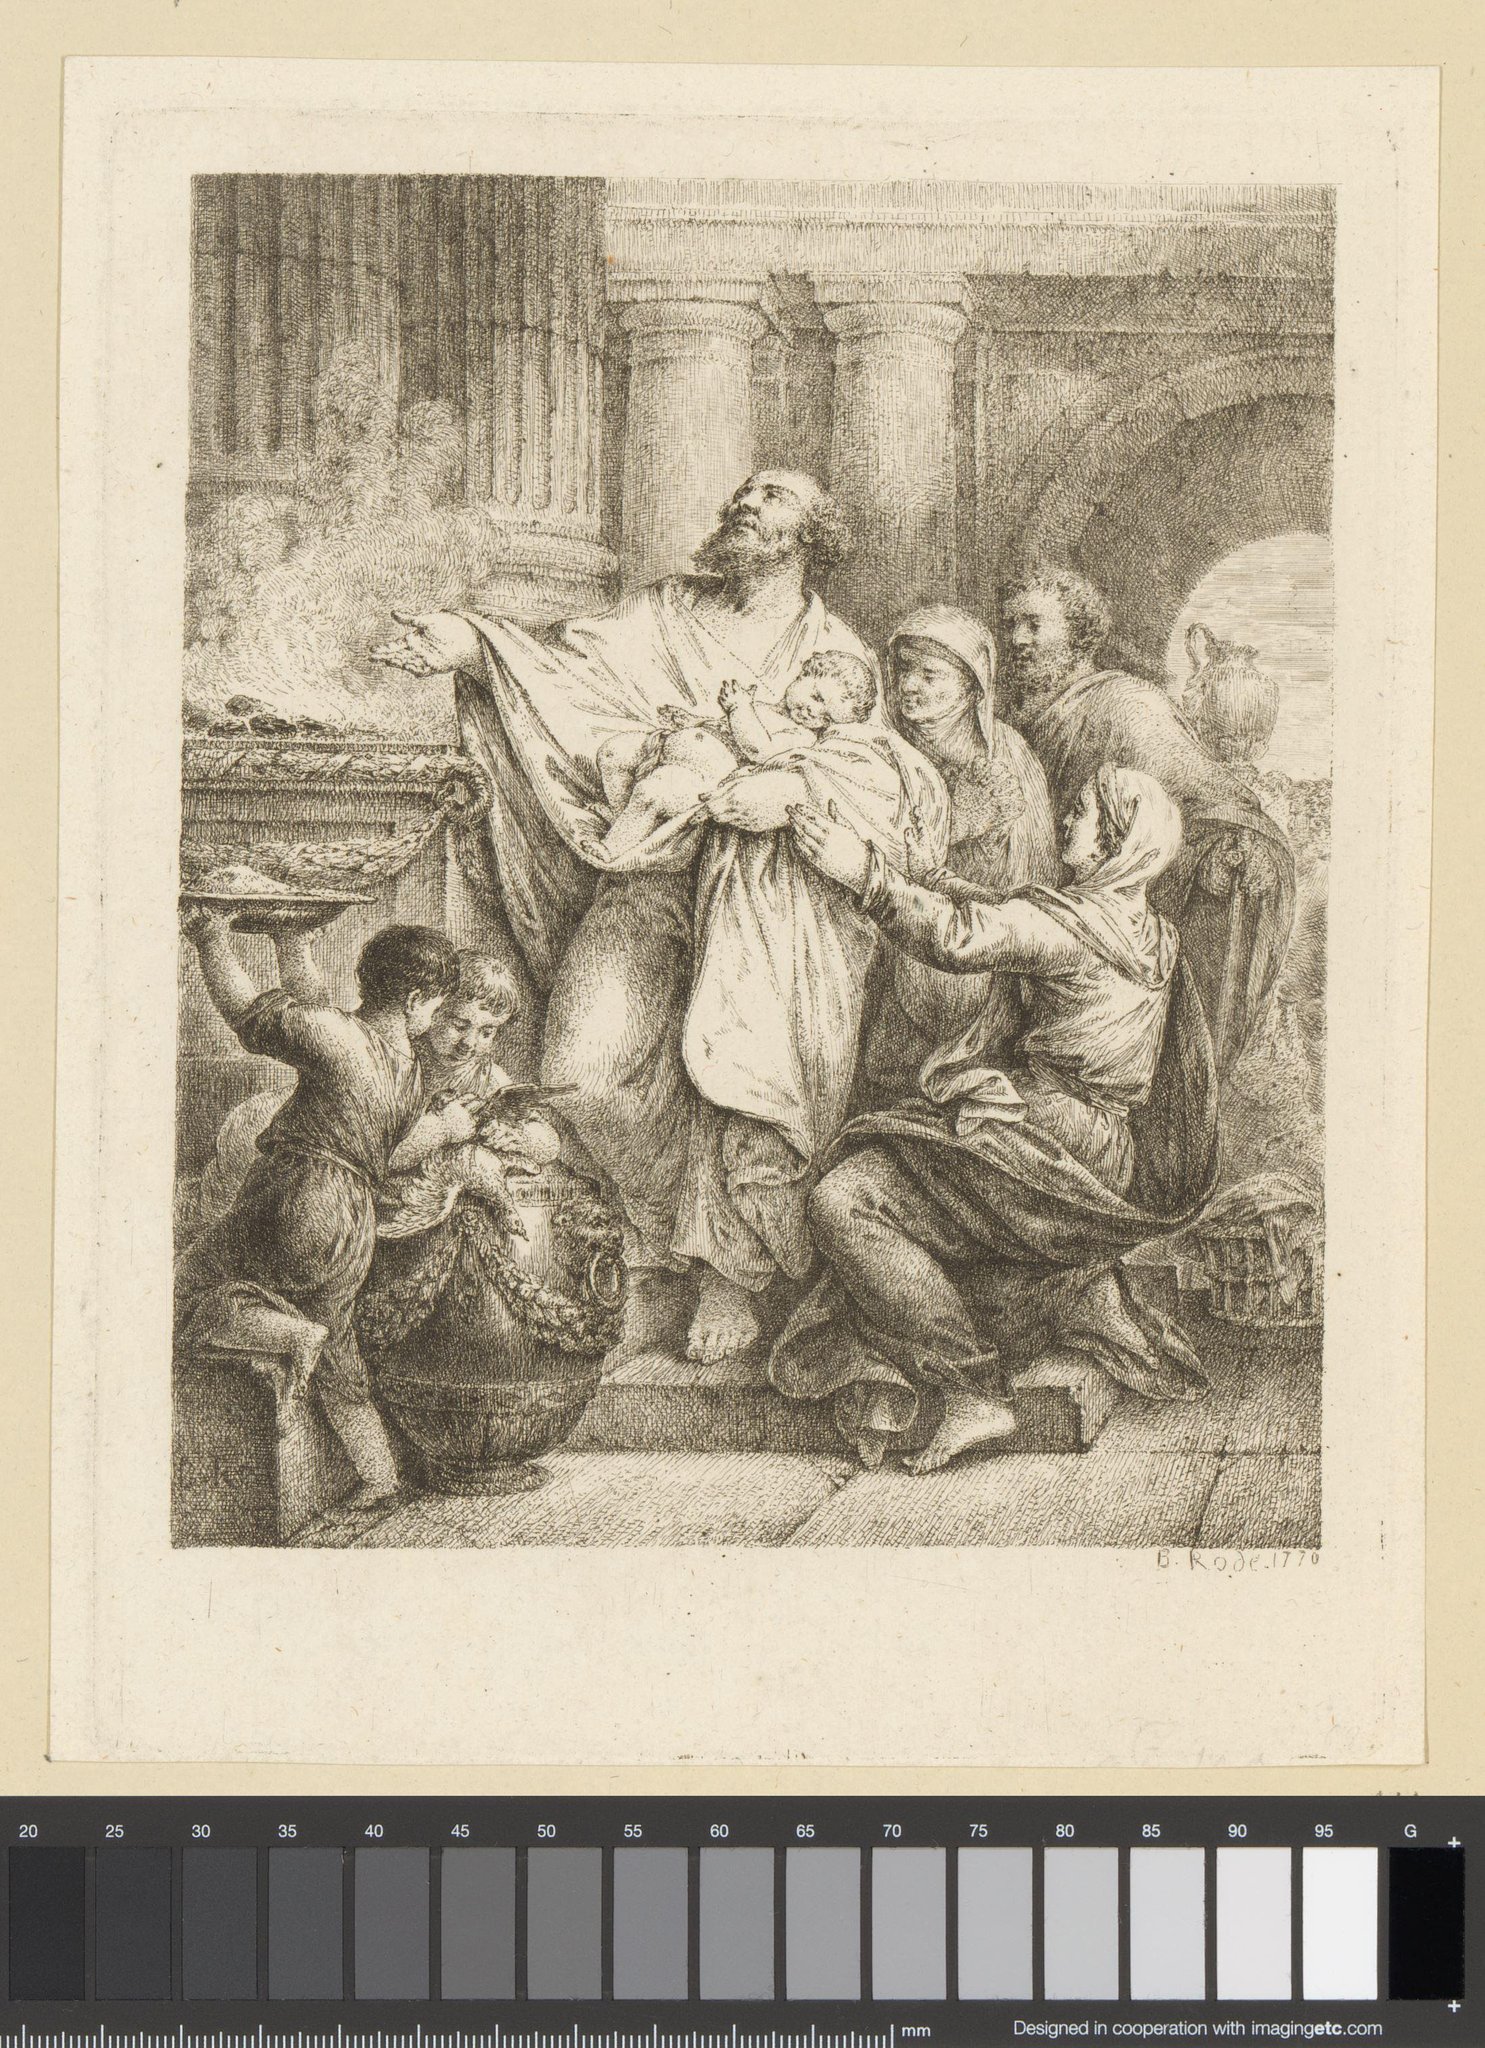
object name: print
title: Presentatie in de tempel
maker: bernhard rode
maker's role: artist, print maker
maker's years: 1725-1797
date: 1776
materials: paper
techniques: etching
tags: presentation of the christ-child in the temple, usually simeon (and anna) present (luke 2:22-39)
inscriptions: collector's mark: Lugt 240